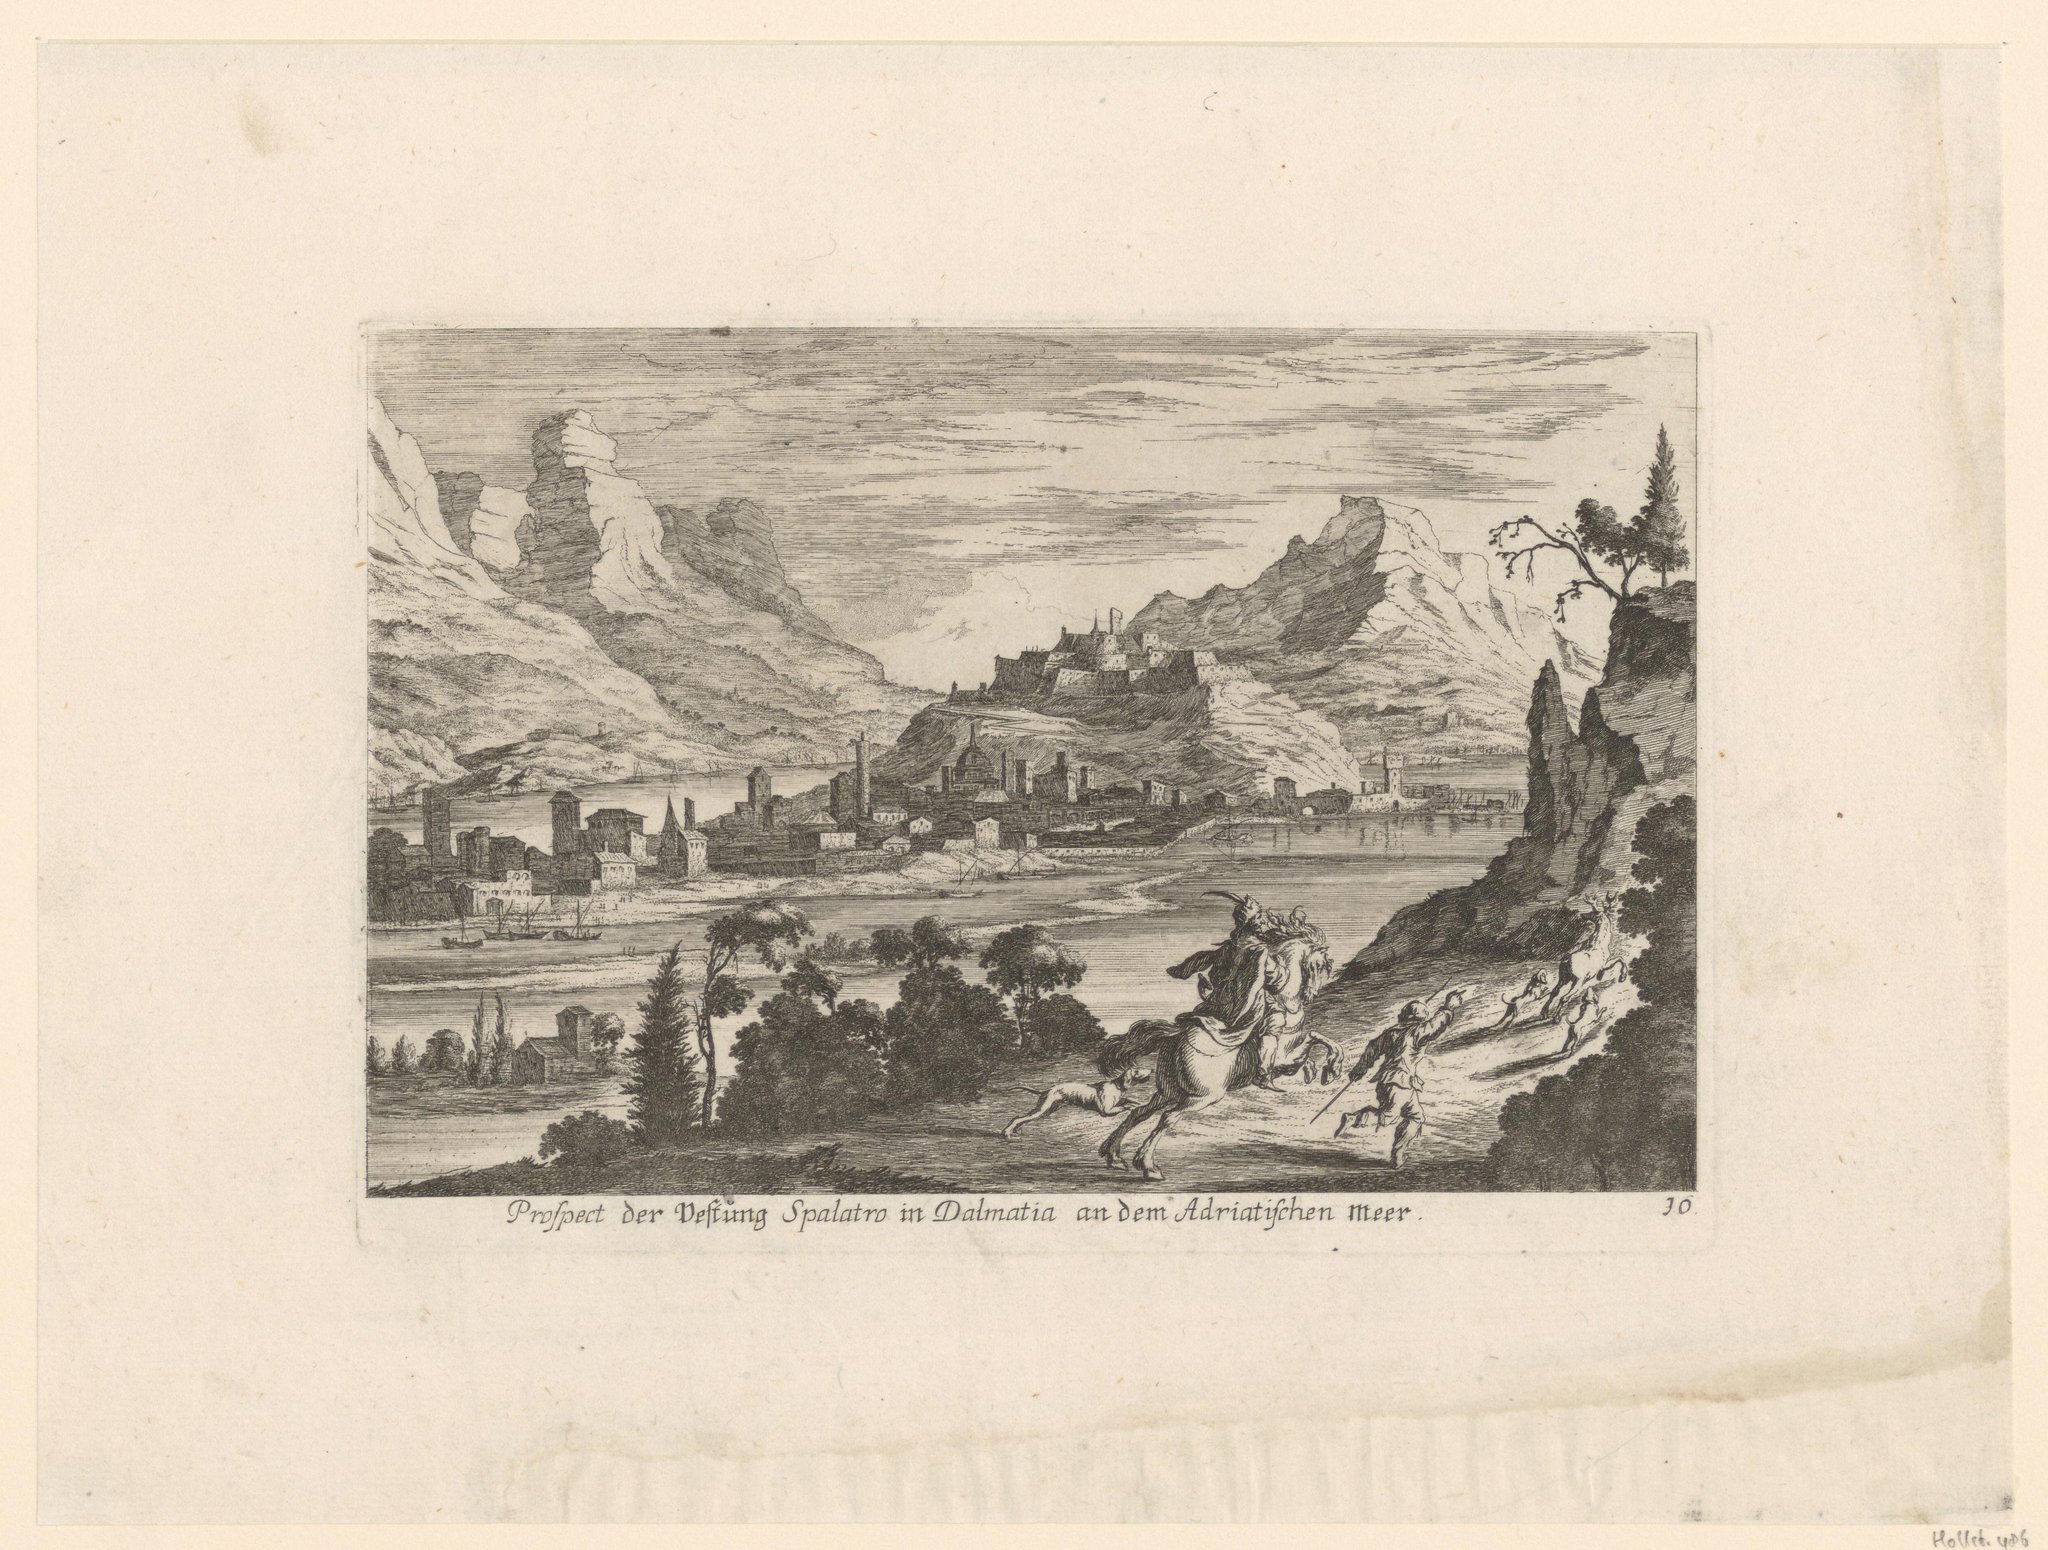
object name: print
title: Schöne und Wahre Landschafften in Italien und andern Landern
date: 1670-1719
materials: paper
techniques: etching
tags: hunters hunting (n.b.: in 1988-1990 this notation denoted the concept of 43c11421 'hunters resting during the hunt'), rocky coast, city-view, and landscape with man-made constructions (+ city(-scape) with figures, staffage)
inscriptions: collector's mark: Lugt 2228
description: Deze prent is deel van de serie: Schöne und Wahre Landschafften in Italien und andern Landern. Augsburg: Johann Ulrich Kraus, 1675-1685. De serie bestaat uit veertien prenten plus een titelprent. Deze uitgave omvat een selectie van de 146 prenten uit de uitgave getiteld 'Joannis Guilielmi Baurn Iconographia completens in se, Passionem (...) Per Italiam, Spectatu Sunt', voor het eerst uitgegeven in Augsburg in 1670.